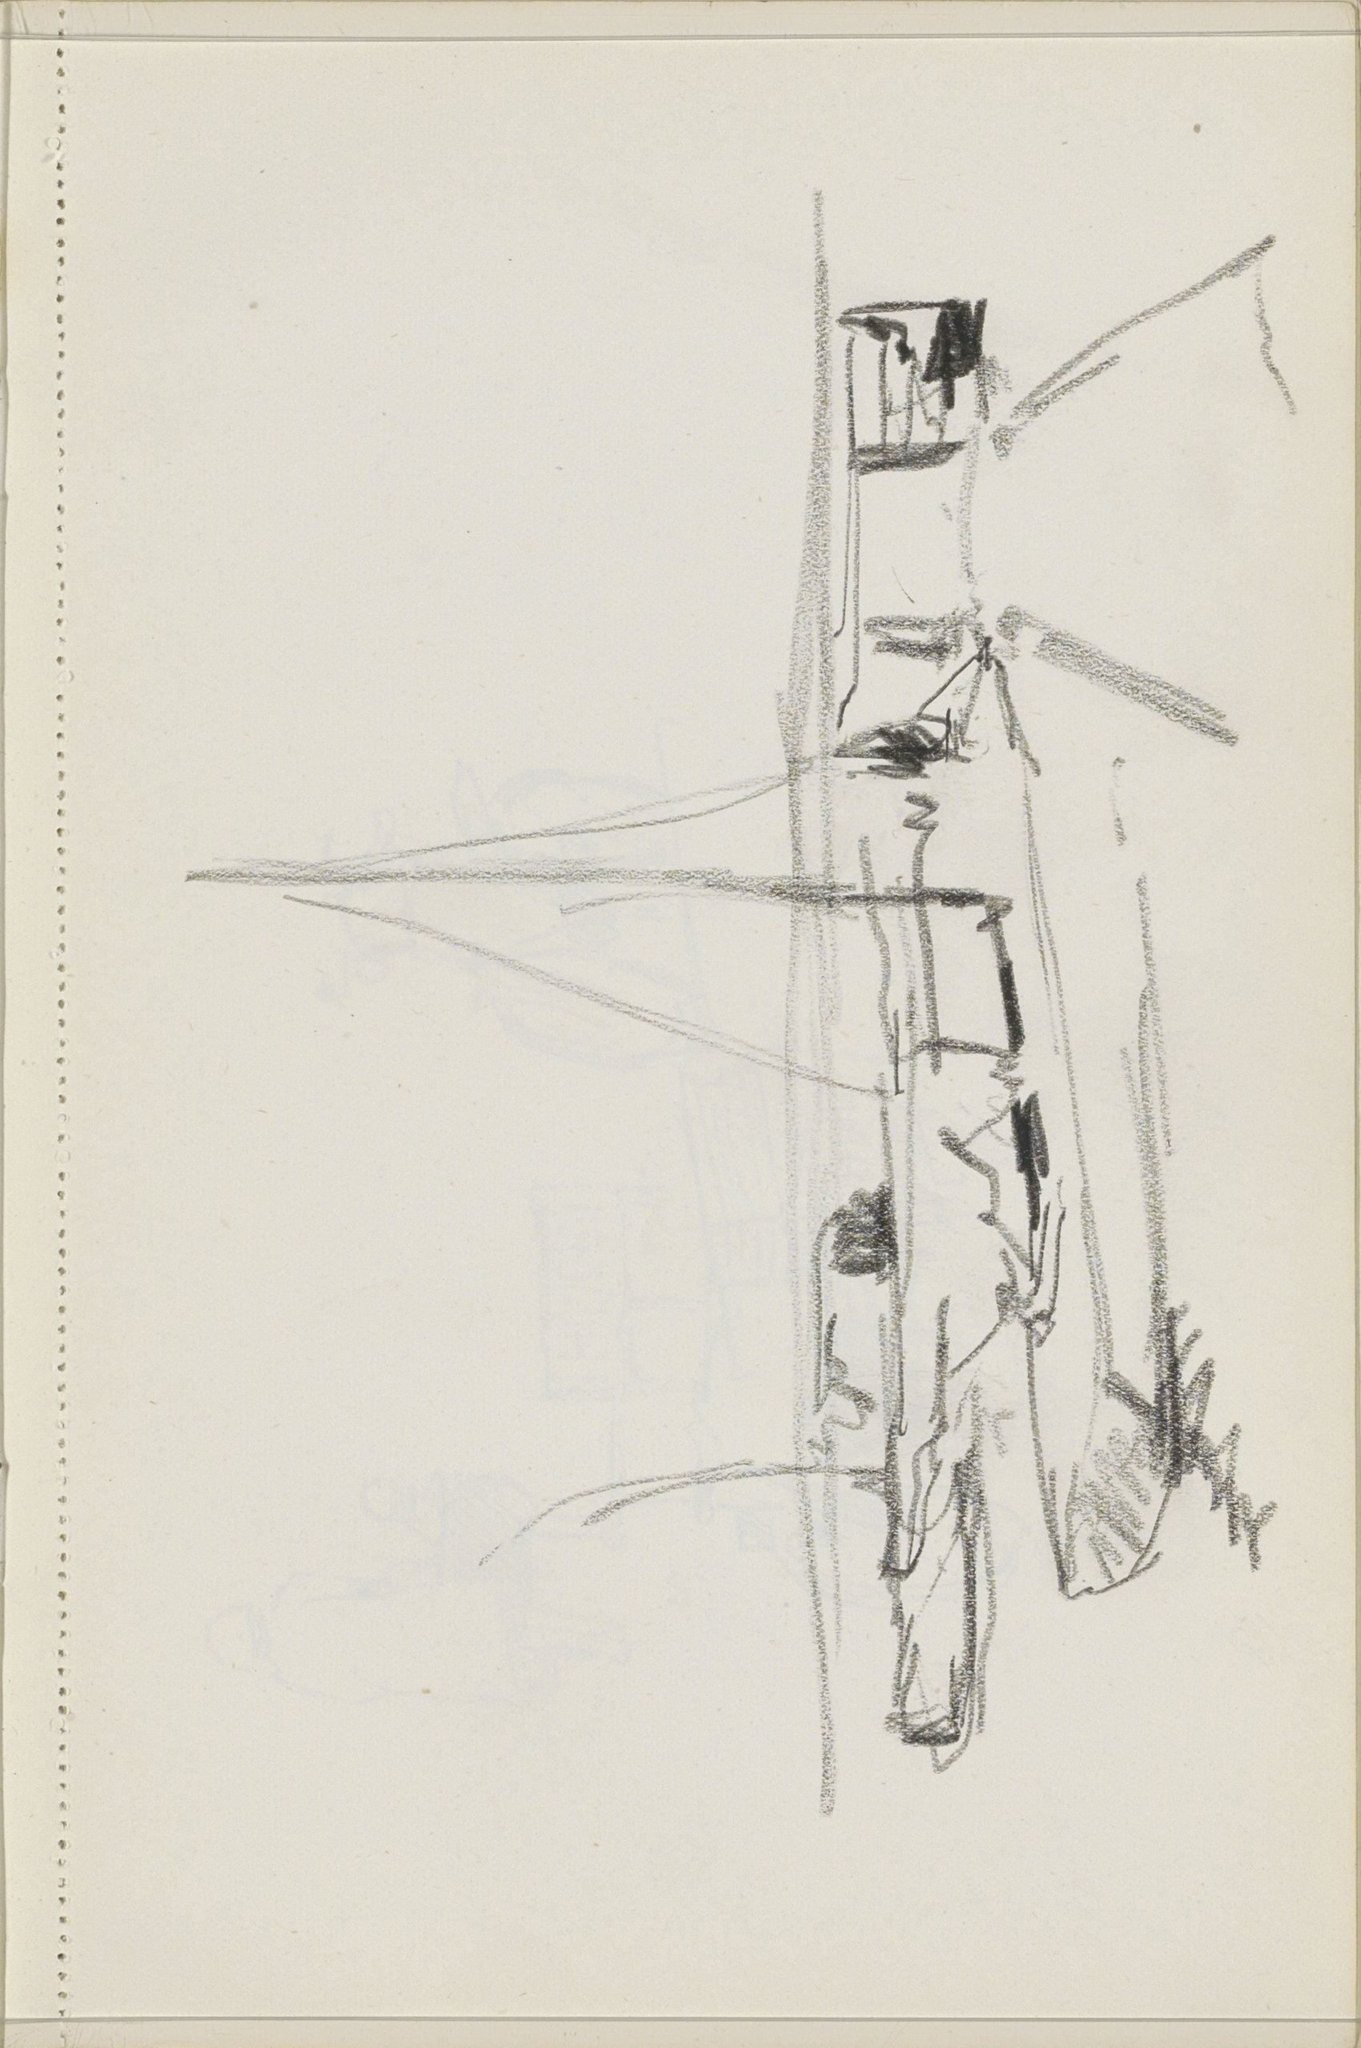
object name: sketchbook leaf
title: Twee zeilboten bij een aanlegsteiger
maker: cornelis vreedenburgh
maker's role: draughtsman, print maker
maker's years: 1880-1946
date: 1890-1946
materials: chalk, paper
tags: sailing-ship, sailing-boat, pier, quay, wharf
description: Blad 10 recto uit een schetsboek met uit 75 bladen.